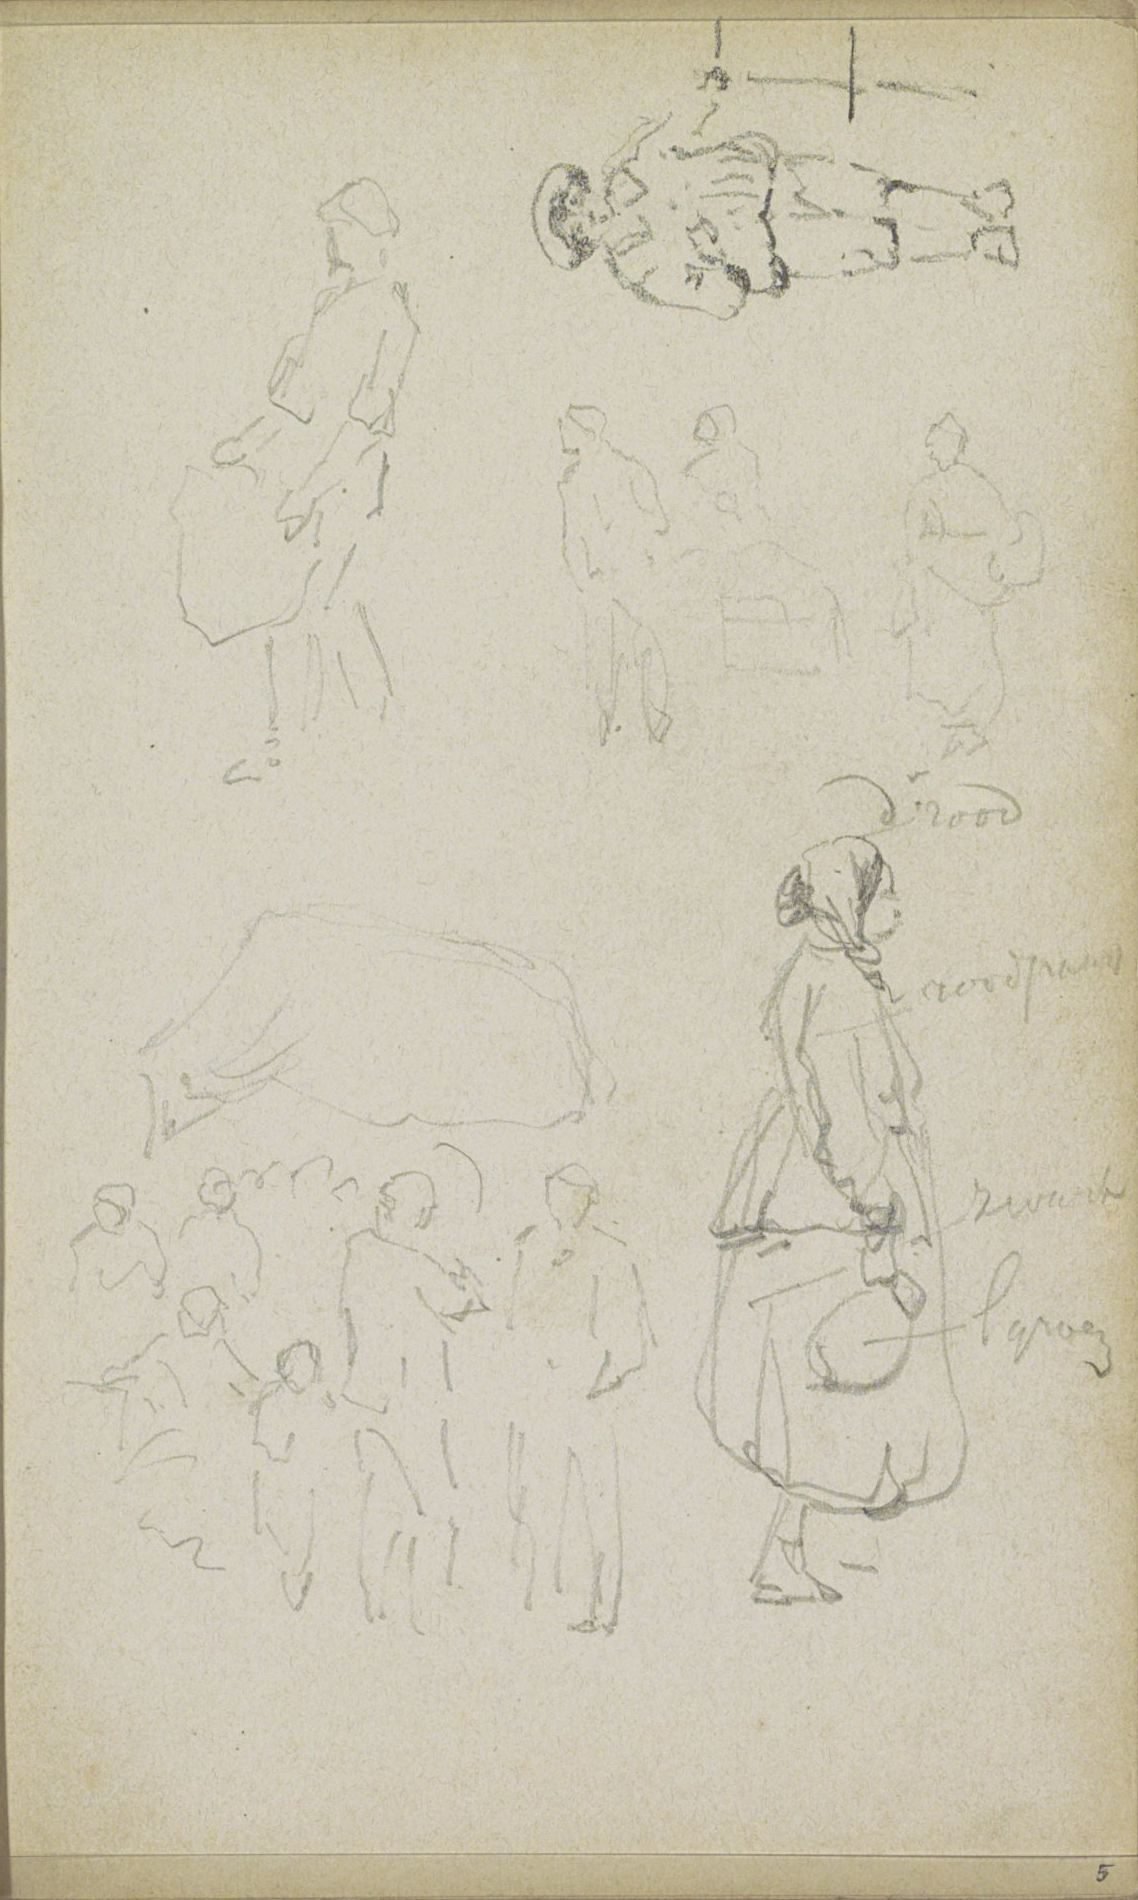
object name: sketchbook leaf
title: Figuurstudies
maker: adrianus eversen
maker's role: draughtsman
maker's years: 1818-1897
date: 1828-1897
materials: paper, pencil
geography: netherlands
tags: adult woman, adult man, stall, booth (~ market)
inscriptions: kleurnotitie, handgeschreven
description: Figuurstudies van mannen en vrouwen. Linksboven een man die iets zwaars vasthoudt. Linksonder figuren, die mogelijk bij een marktkraam staan. Rechtsonder een vrouw met een hoofddoek en een kruik in haar hand, in profiel ten voeten uit. Blad 5 recto uit een schetsboek met 69 bladen vervaardigd in de omgeving van Delft, Rotterdam, Oudewater en Harlingen.